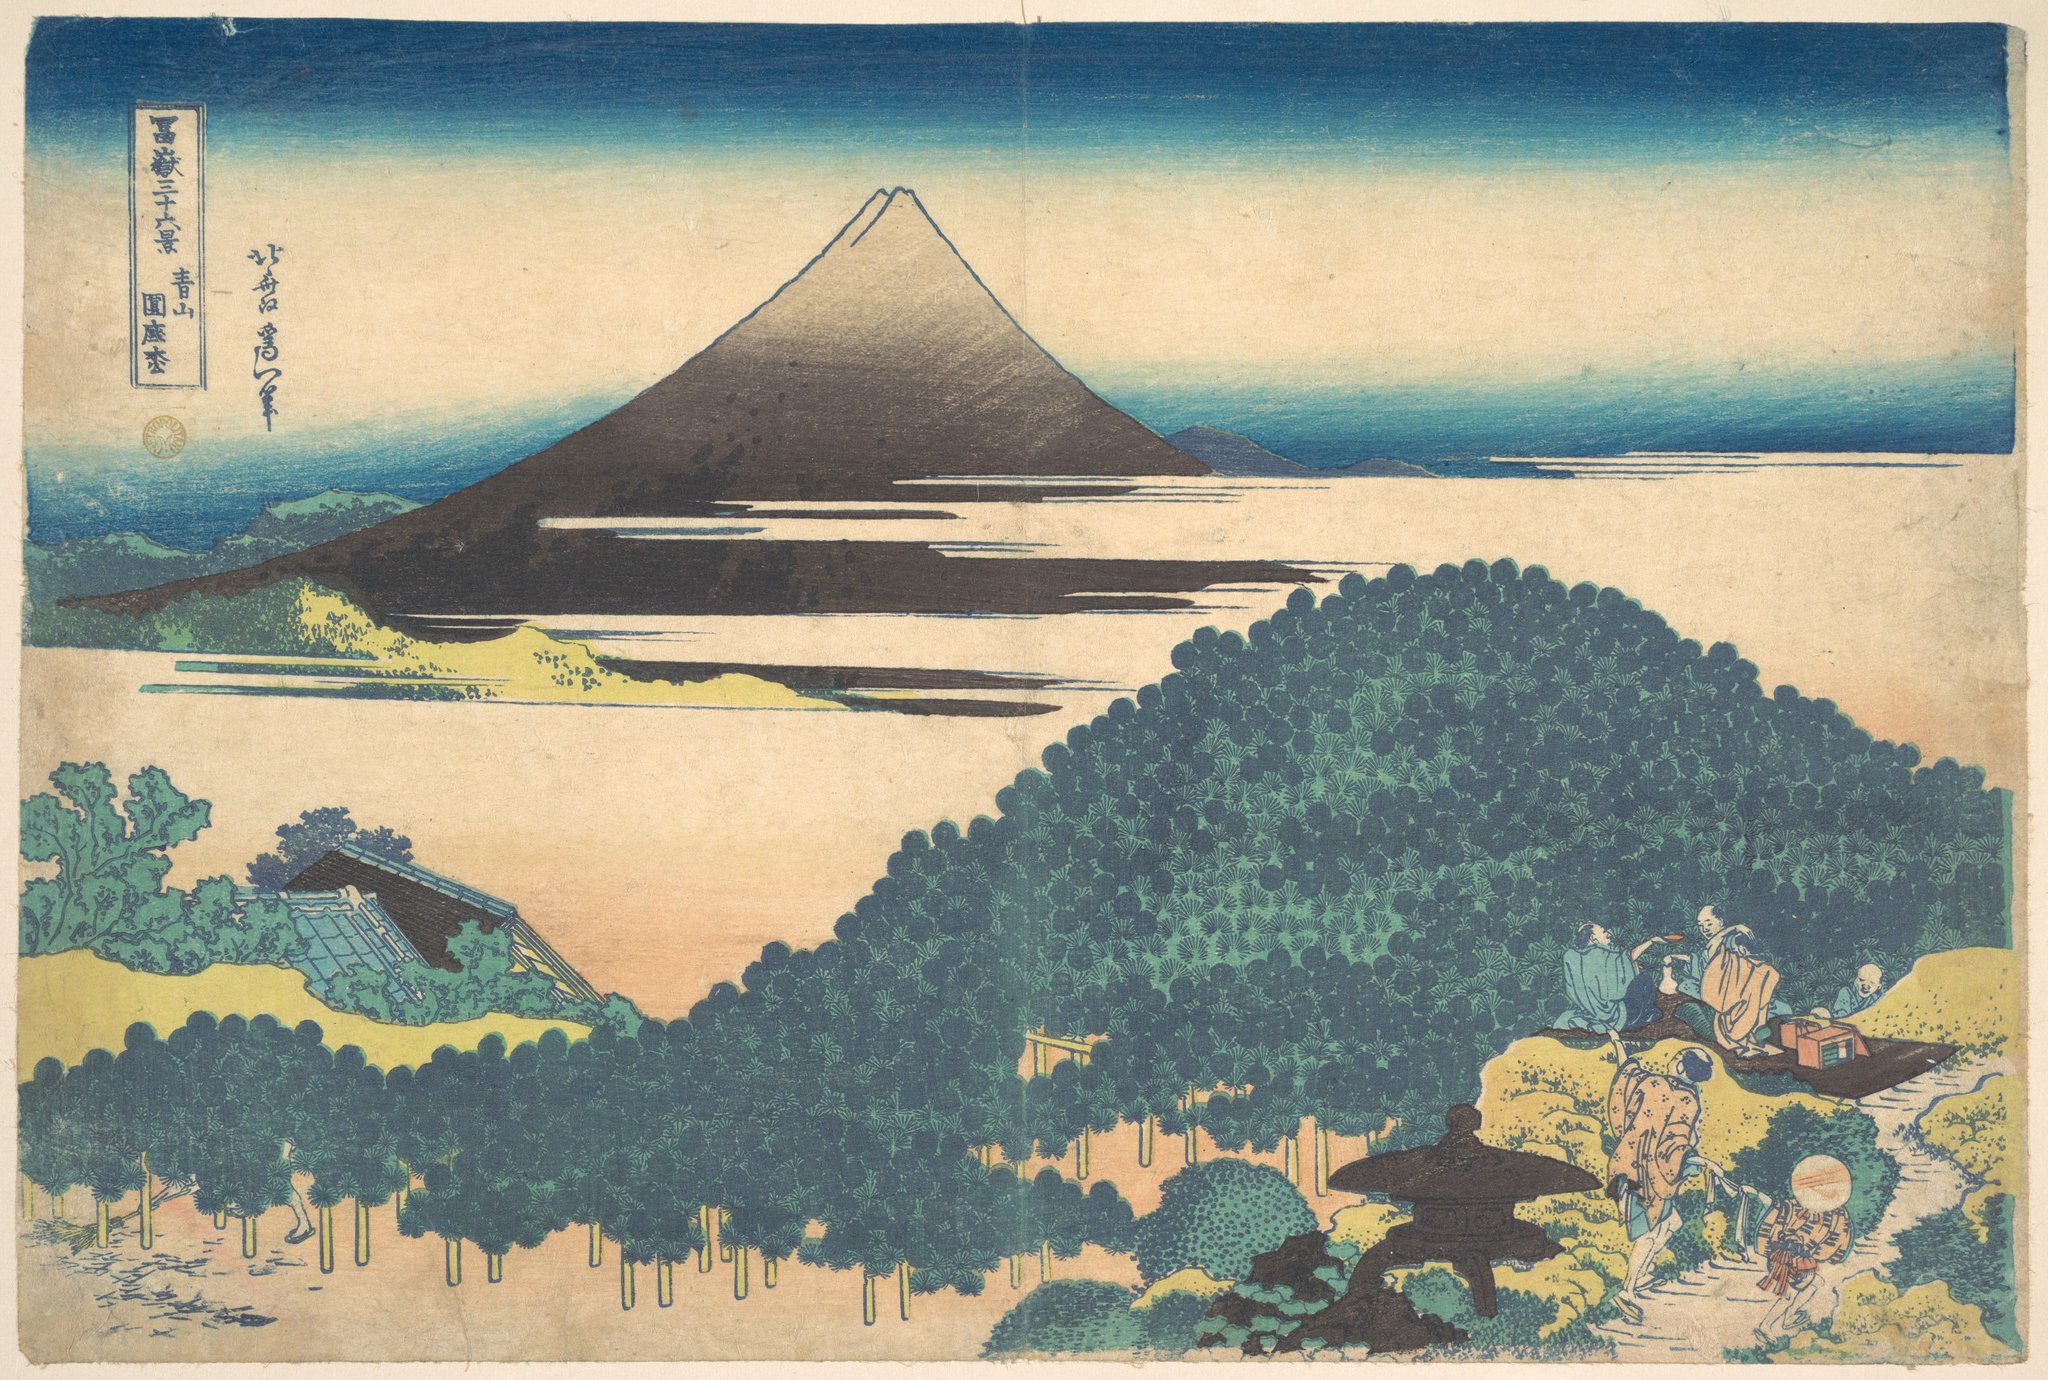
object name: woodblock print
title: Cushion Pine at Aoyama (Aoyama enza no matsu), from the series Thirty-six Views of Mount Fuji (Fugaku sanjūrokkei)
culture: japanese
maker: katsushika hokusai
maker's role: artist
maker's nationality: japanese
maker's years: 1760-1849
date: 1830-1832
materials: ink, paper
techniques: woodblock print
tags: mountains,landscapes,trees